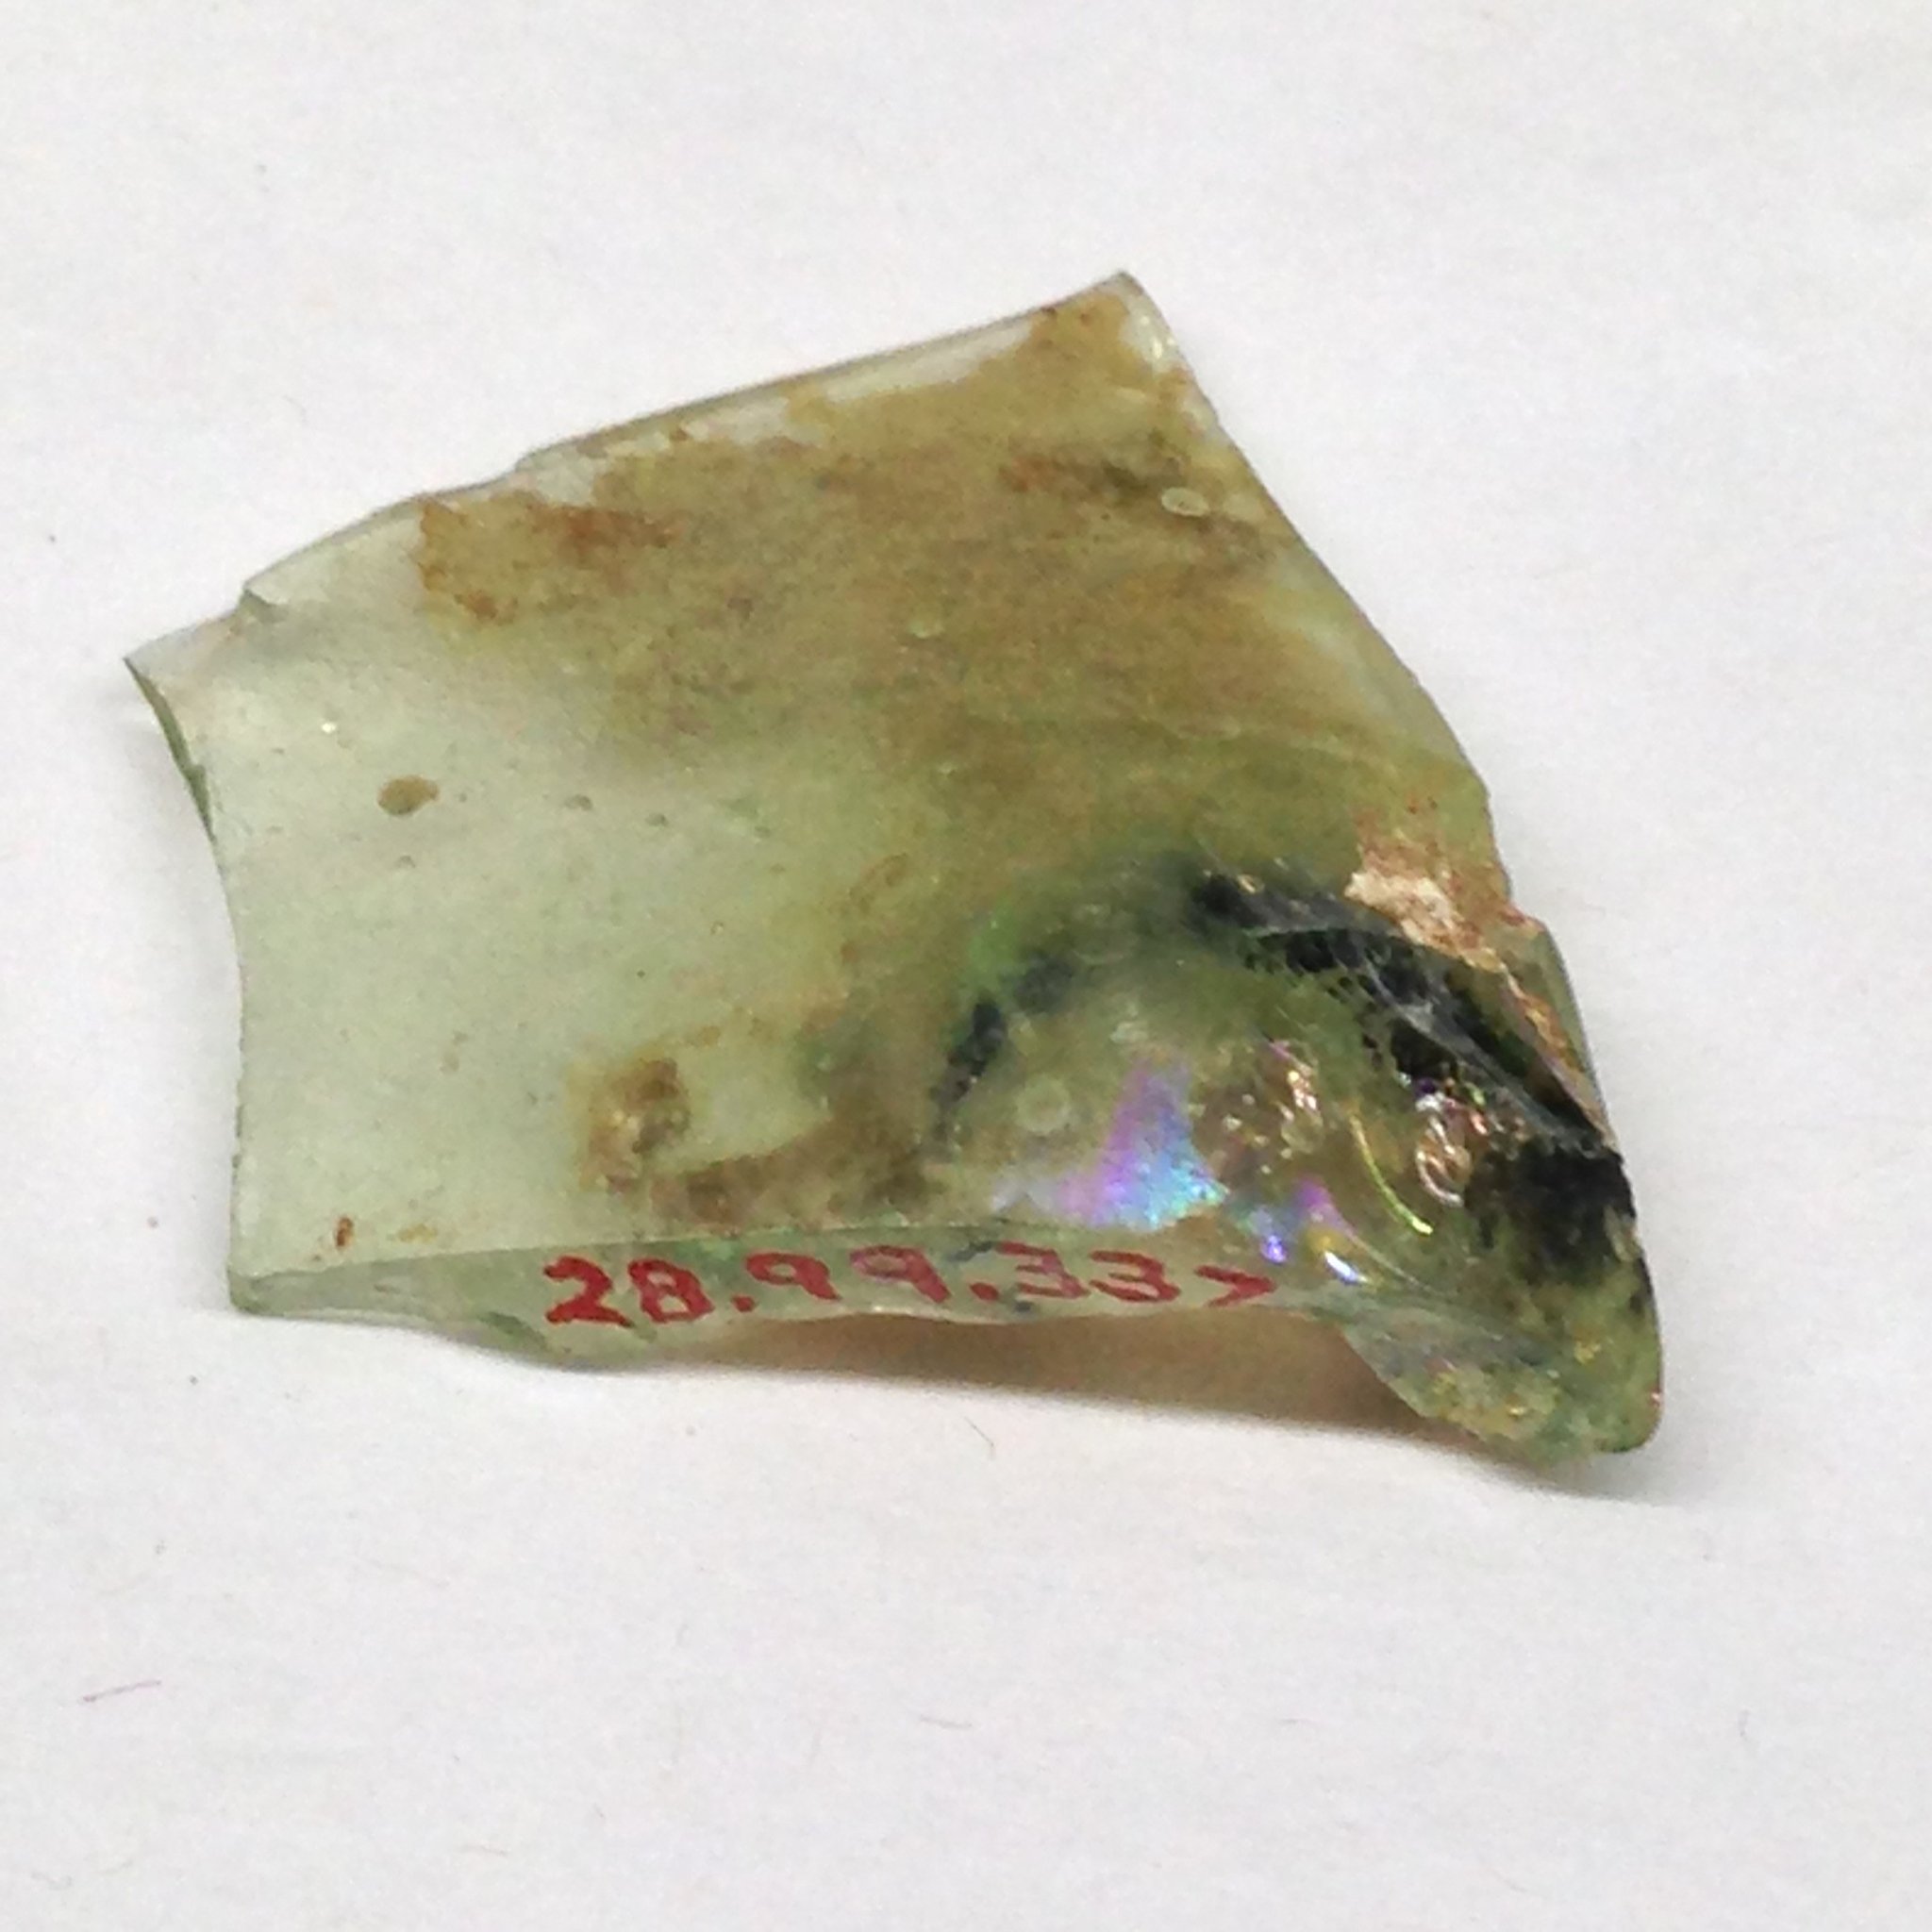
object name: fragment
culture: european or middle eastern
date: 1150-1250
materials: ceramic, glass